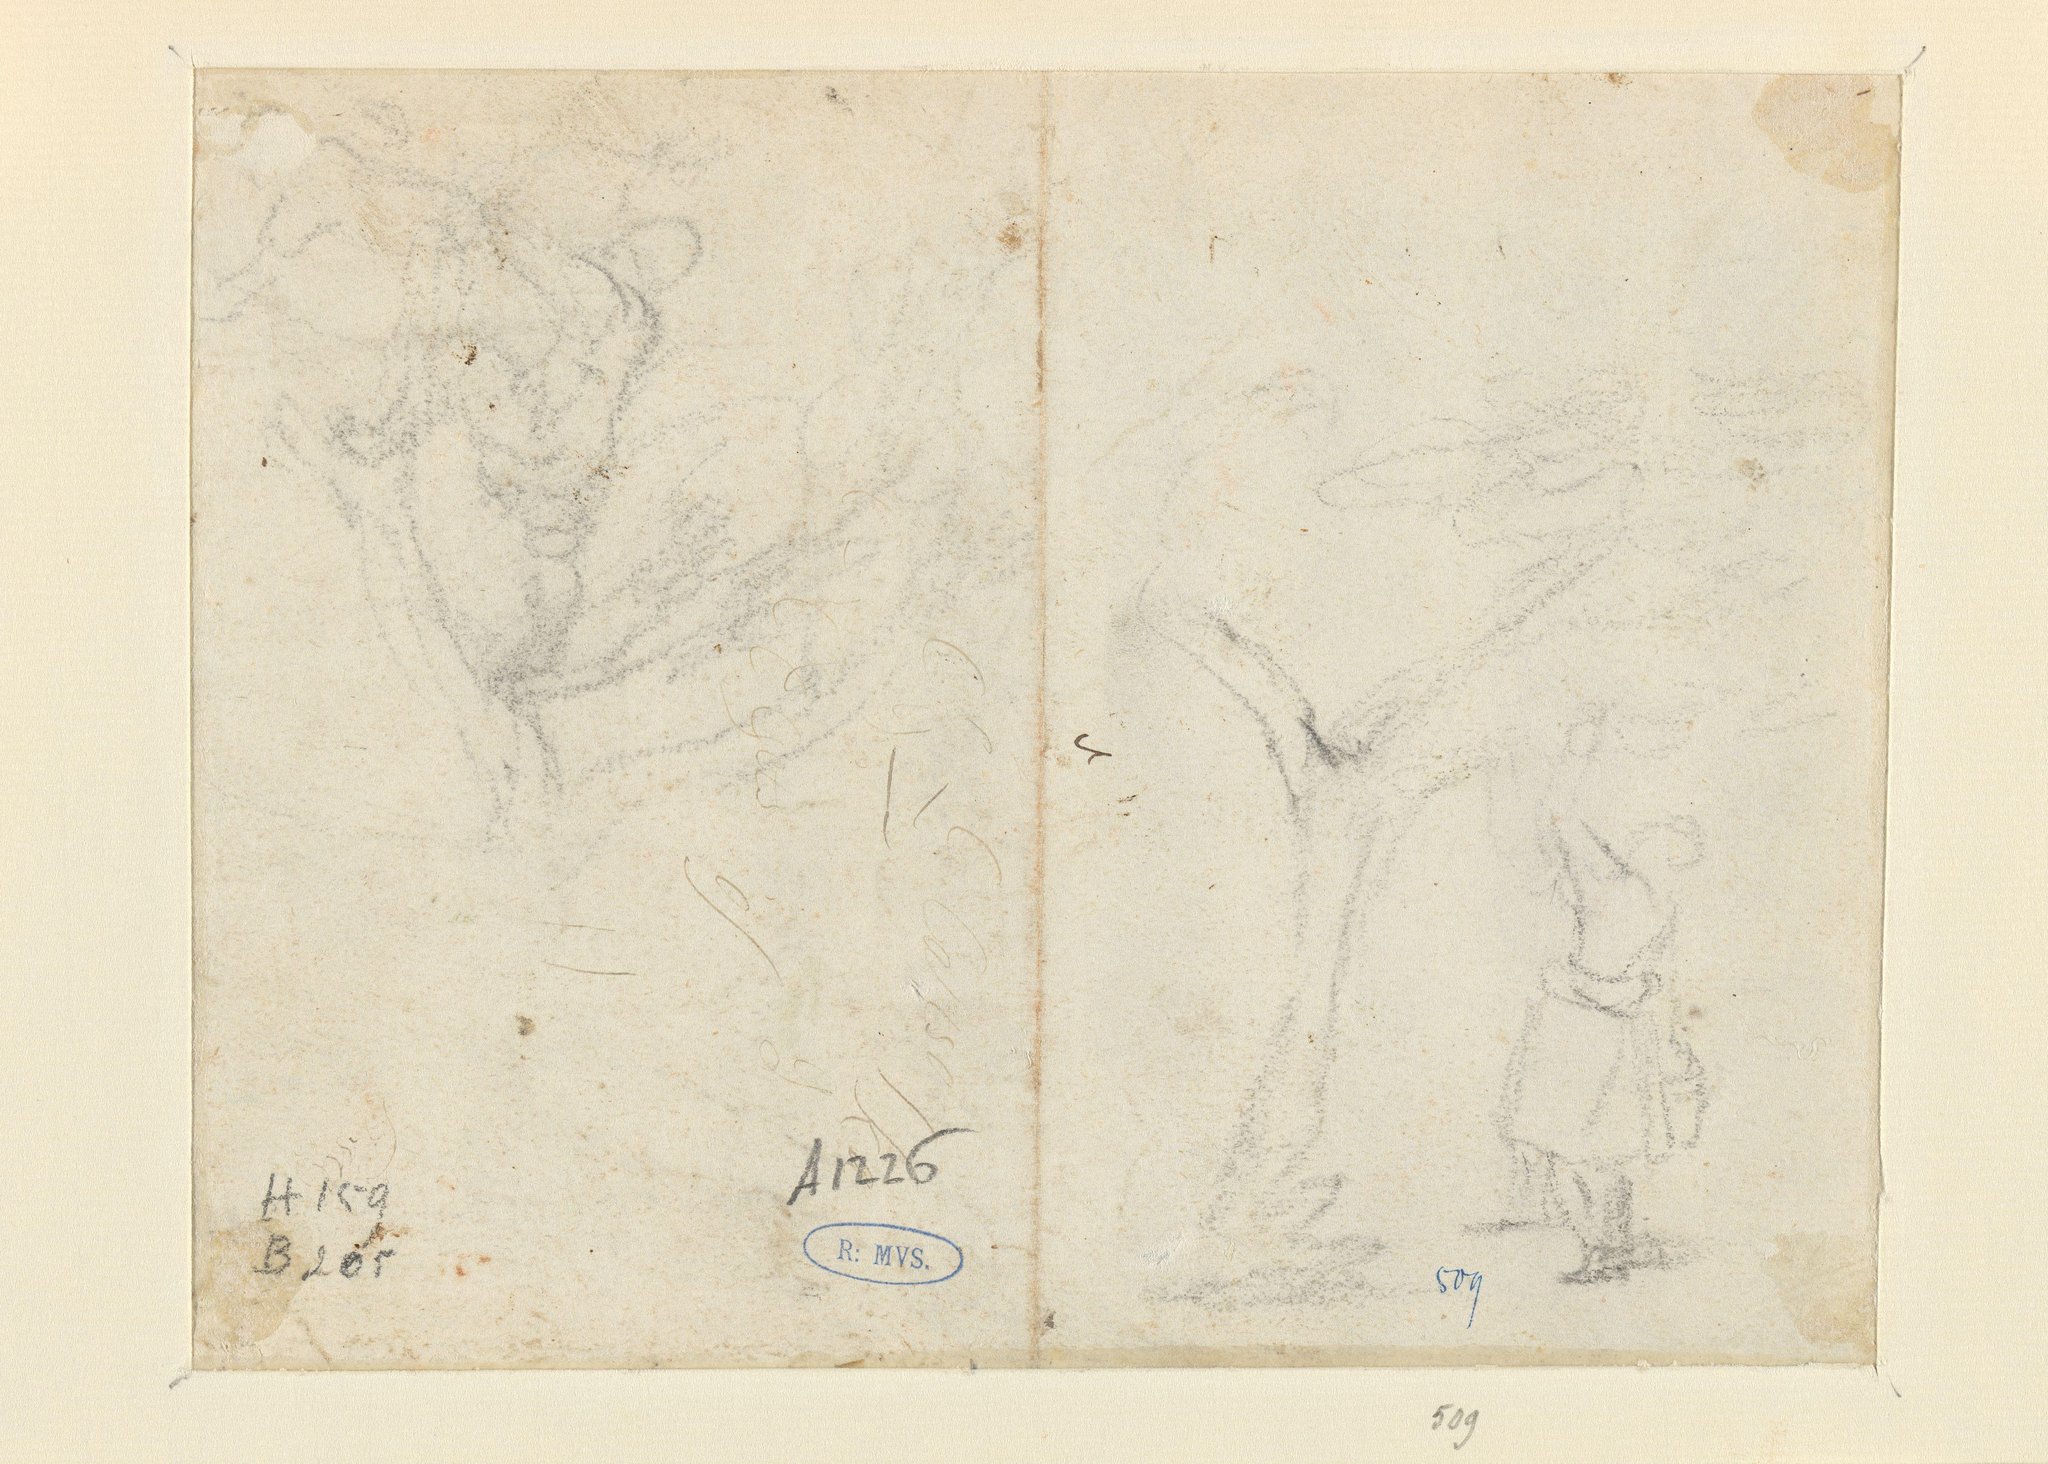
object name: drawing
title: Studieblad met zittende of klimmende man en een staande vrouw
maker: gesina ter borch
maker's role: draughtsman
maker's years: 1633-1690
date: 1652-1658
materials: paper, pencil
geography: zwolle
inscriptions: inscription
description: Studieblad met zittende of in een boom klimmende man en een staande vrouw die naar een boom reikt om fruit te plukken.